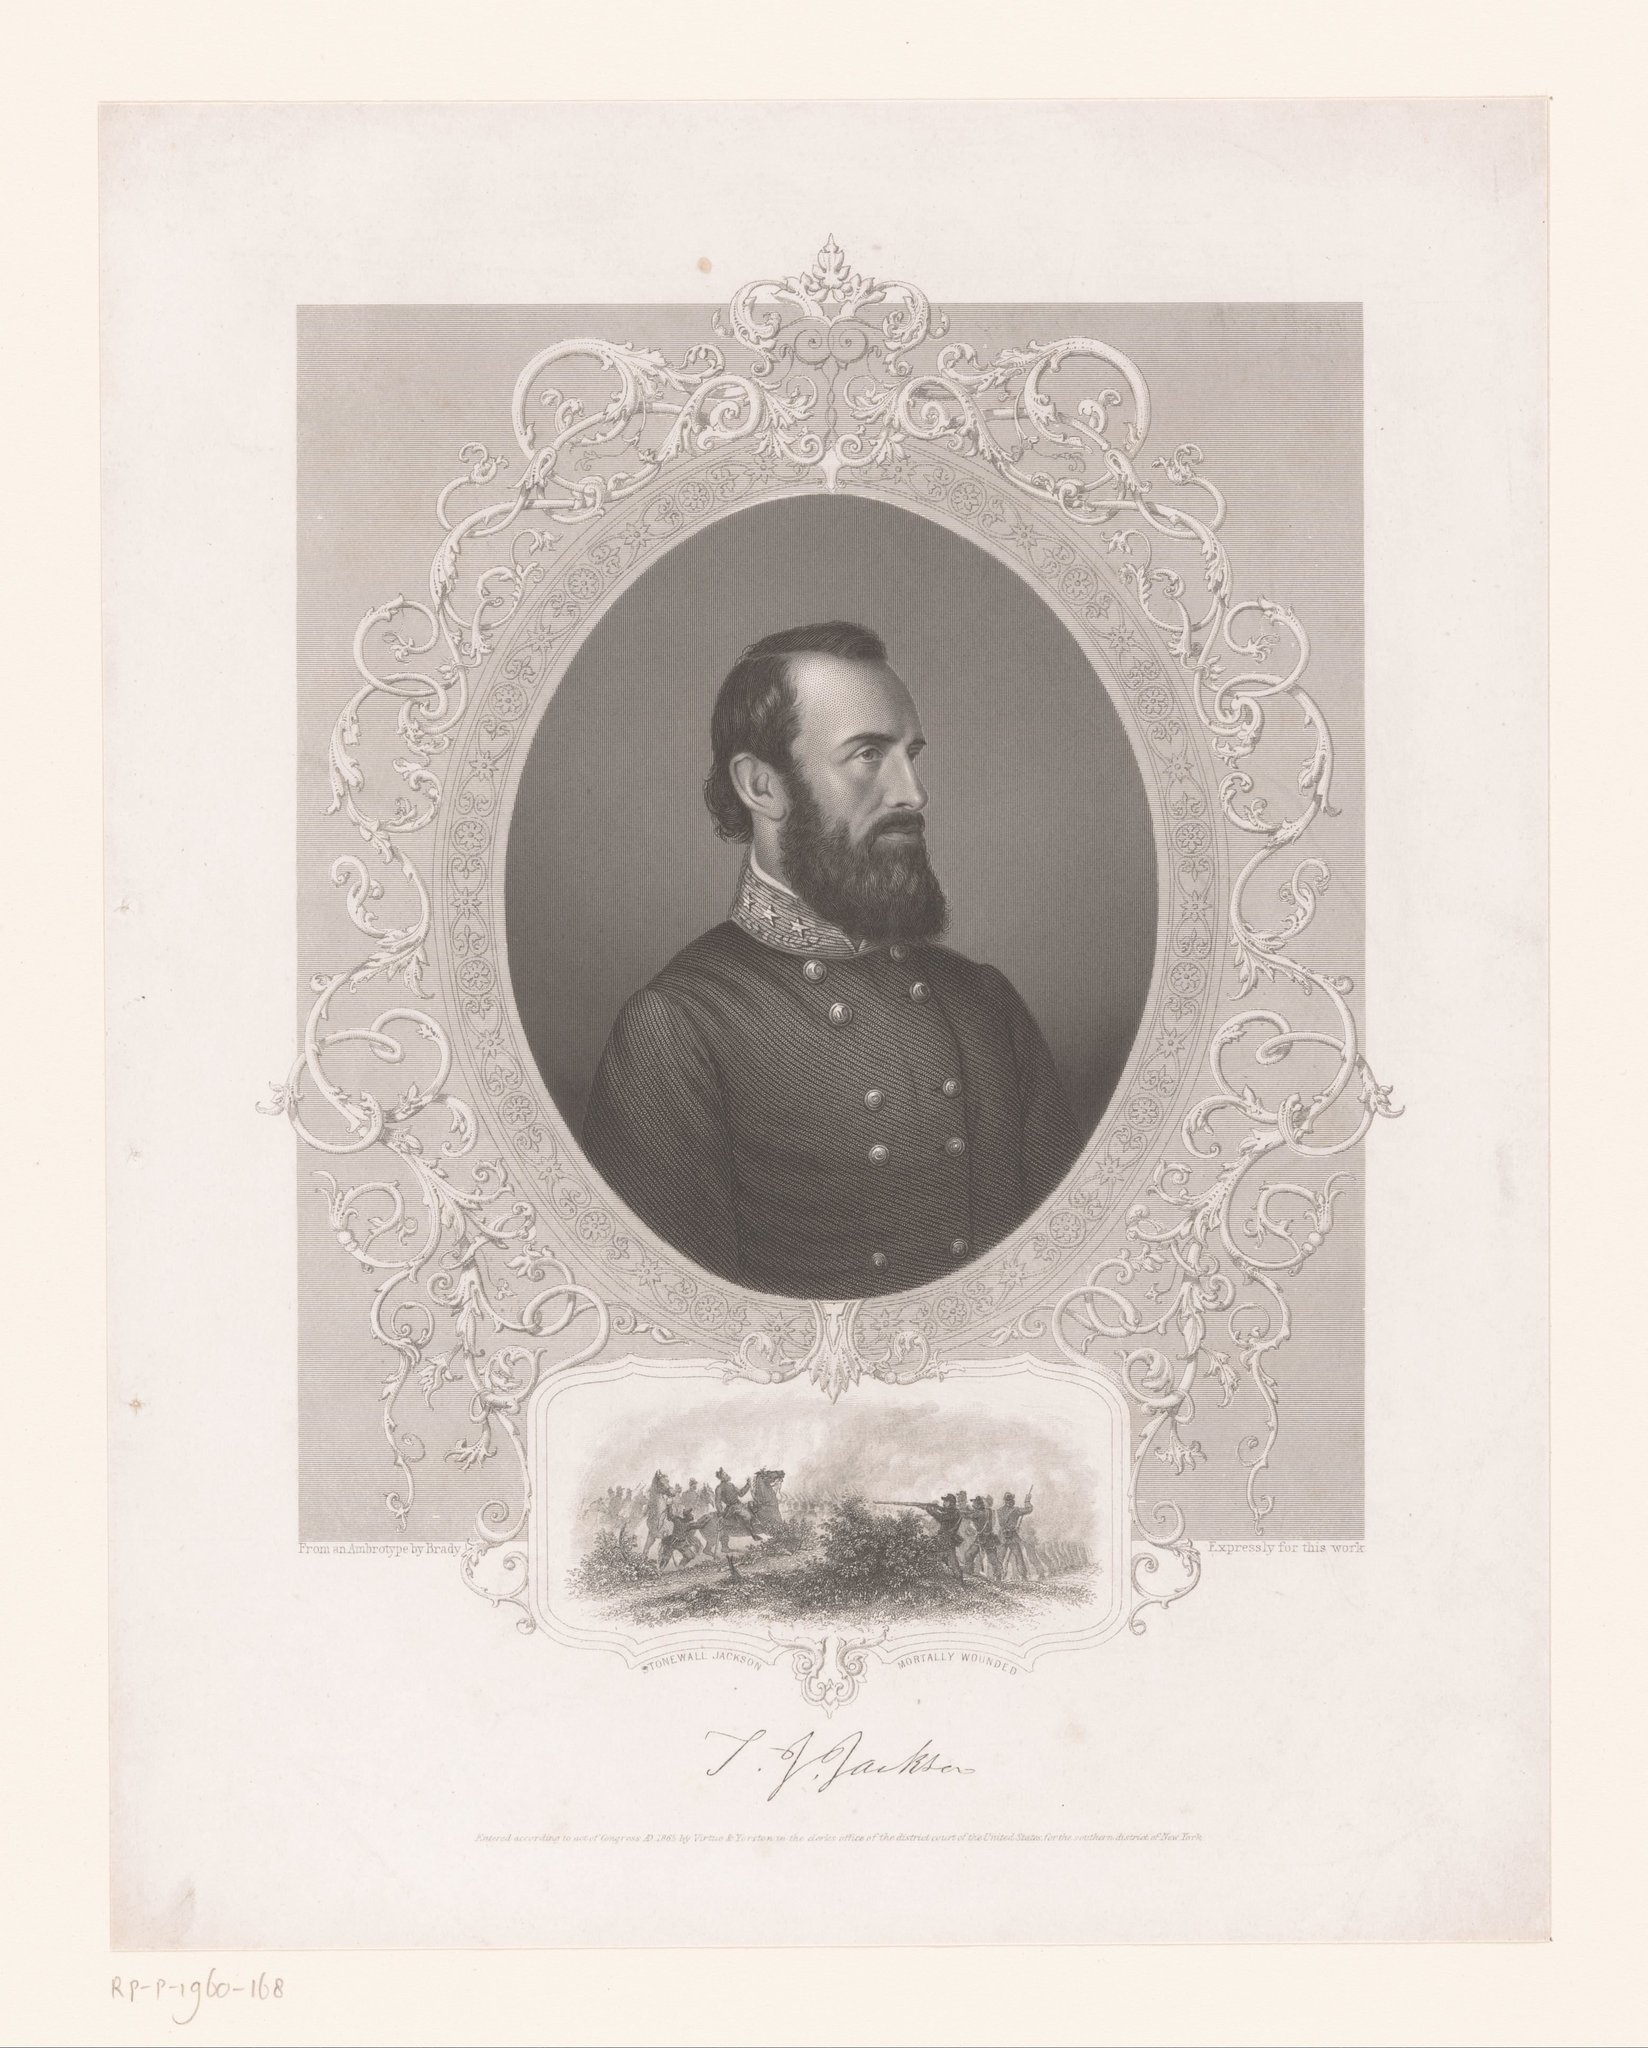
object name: print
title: Portret van generaal Stonewall Jackson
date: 1863-1890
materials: paper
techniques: engraving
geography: new york city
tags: commander-in-chief, general, marshal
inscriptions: collector's mark: Lugt 2228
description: Portret van generaal Thomas Jonathan "Stonewall" Jackson, Ovaal, ten halven lijve, naar rechts. Onder het portret een kleine scène van het gevecht in 1863 waarbij Jackson dodelijk gewond raakt en zijn handtekening. Naar de foto van Brady uit 1863.